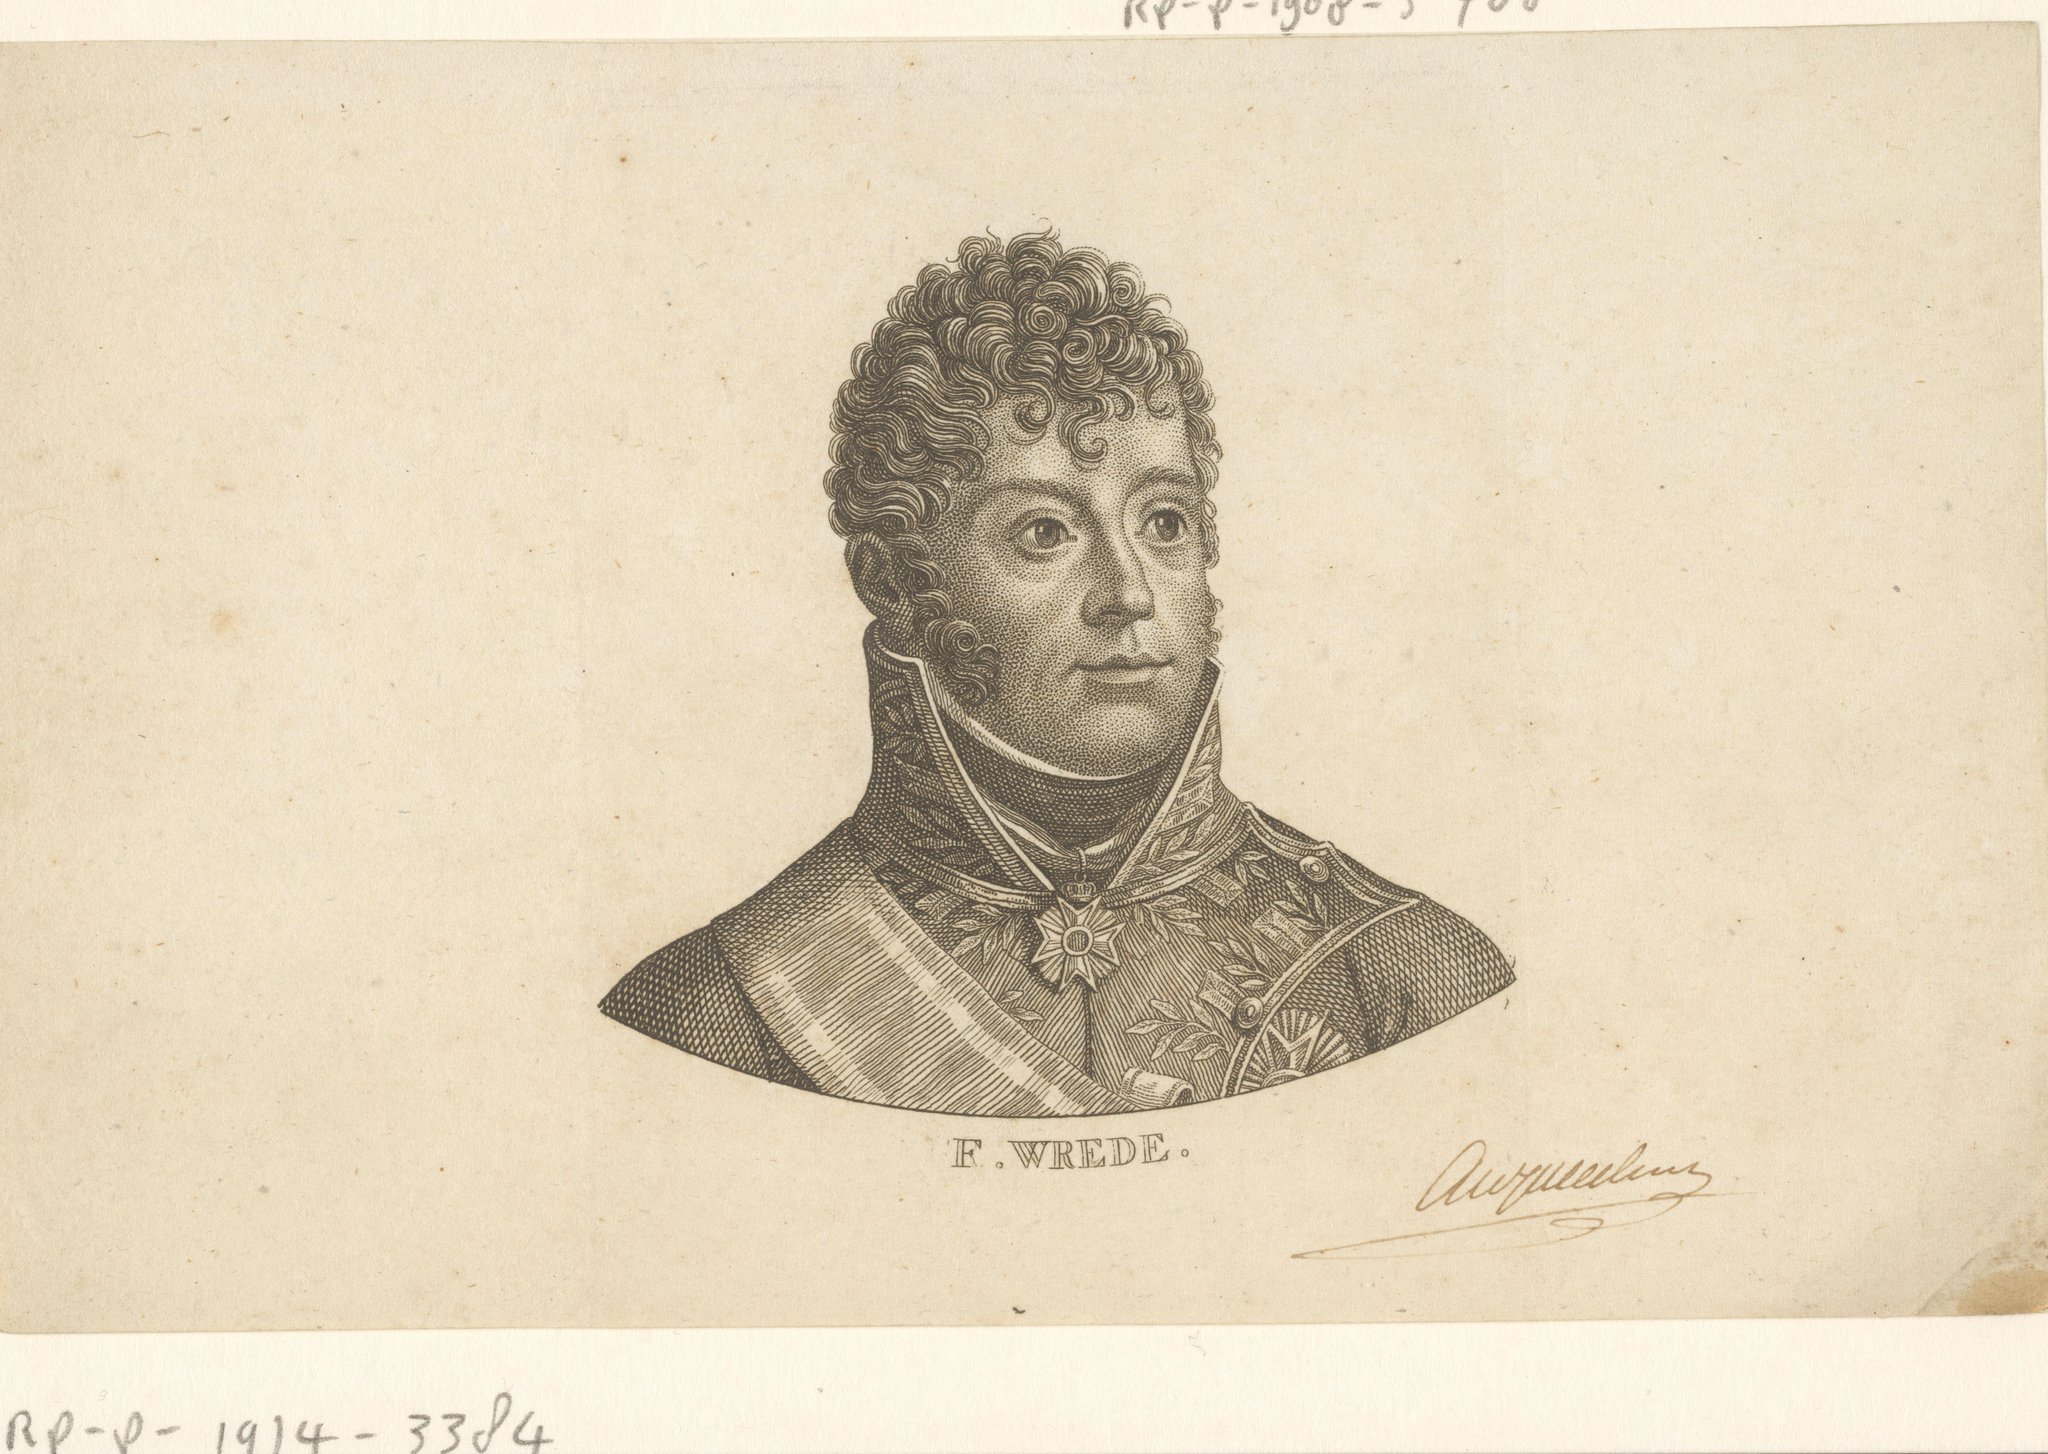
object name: print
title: Portret van Carl Philipp von Wrede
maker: ernst ludwig riepenhausen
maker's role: print maker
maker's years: 1765-1840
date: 1775-1840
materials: paper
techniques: engraving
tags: historical persons, medals and other marks of military honour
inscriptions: name, collector's mark: Lugt 2228